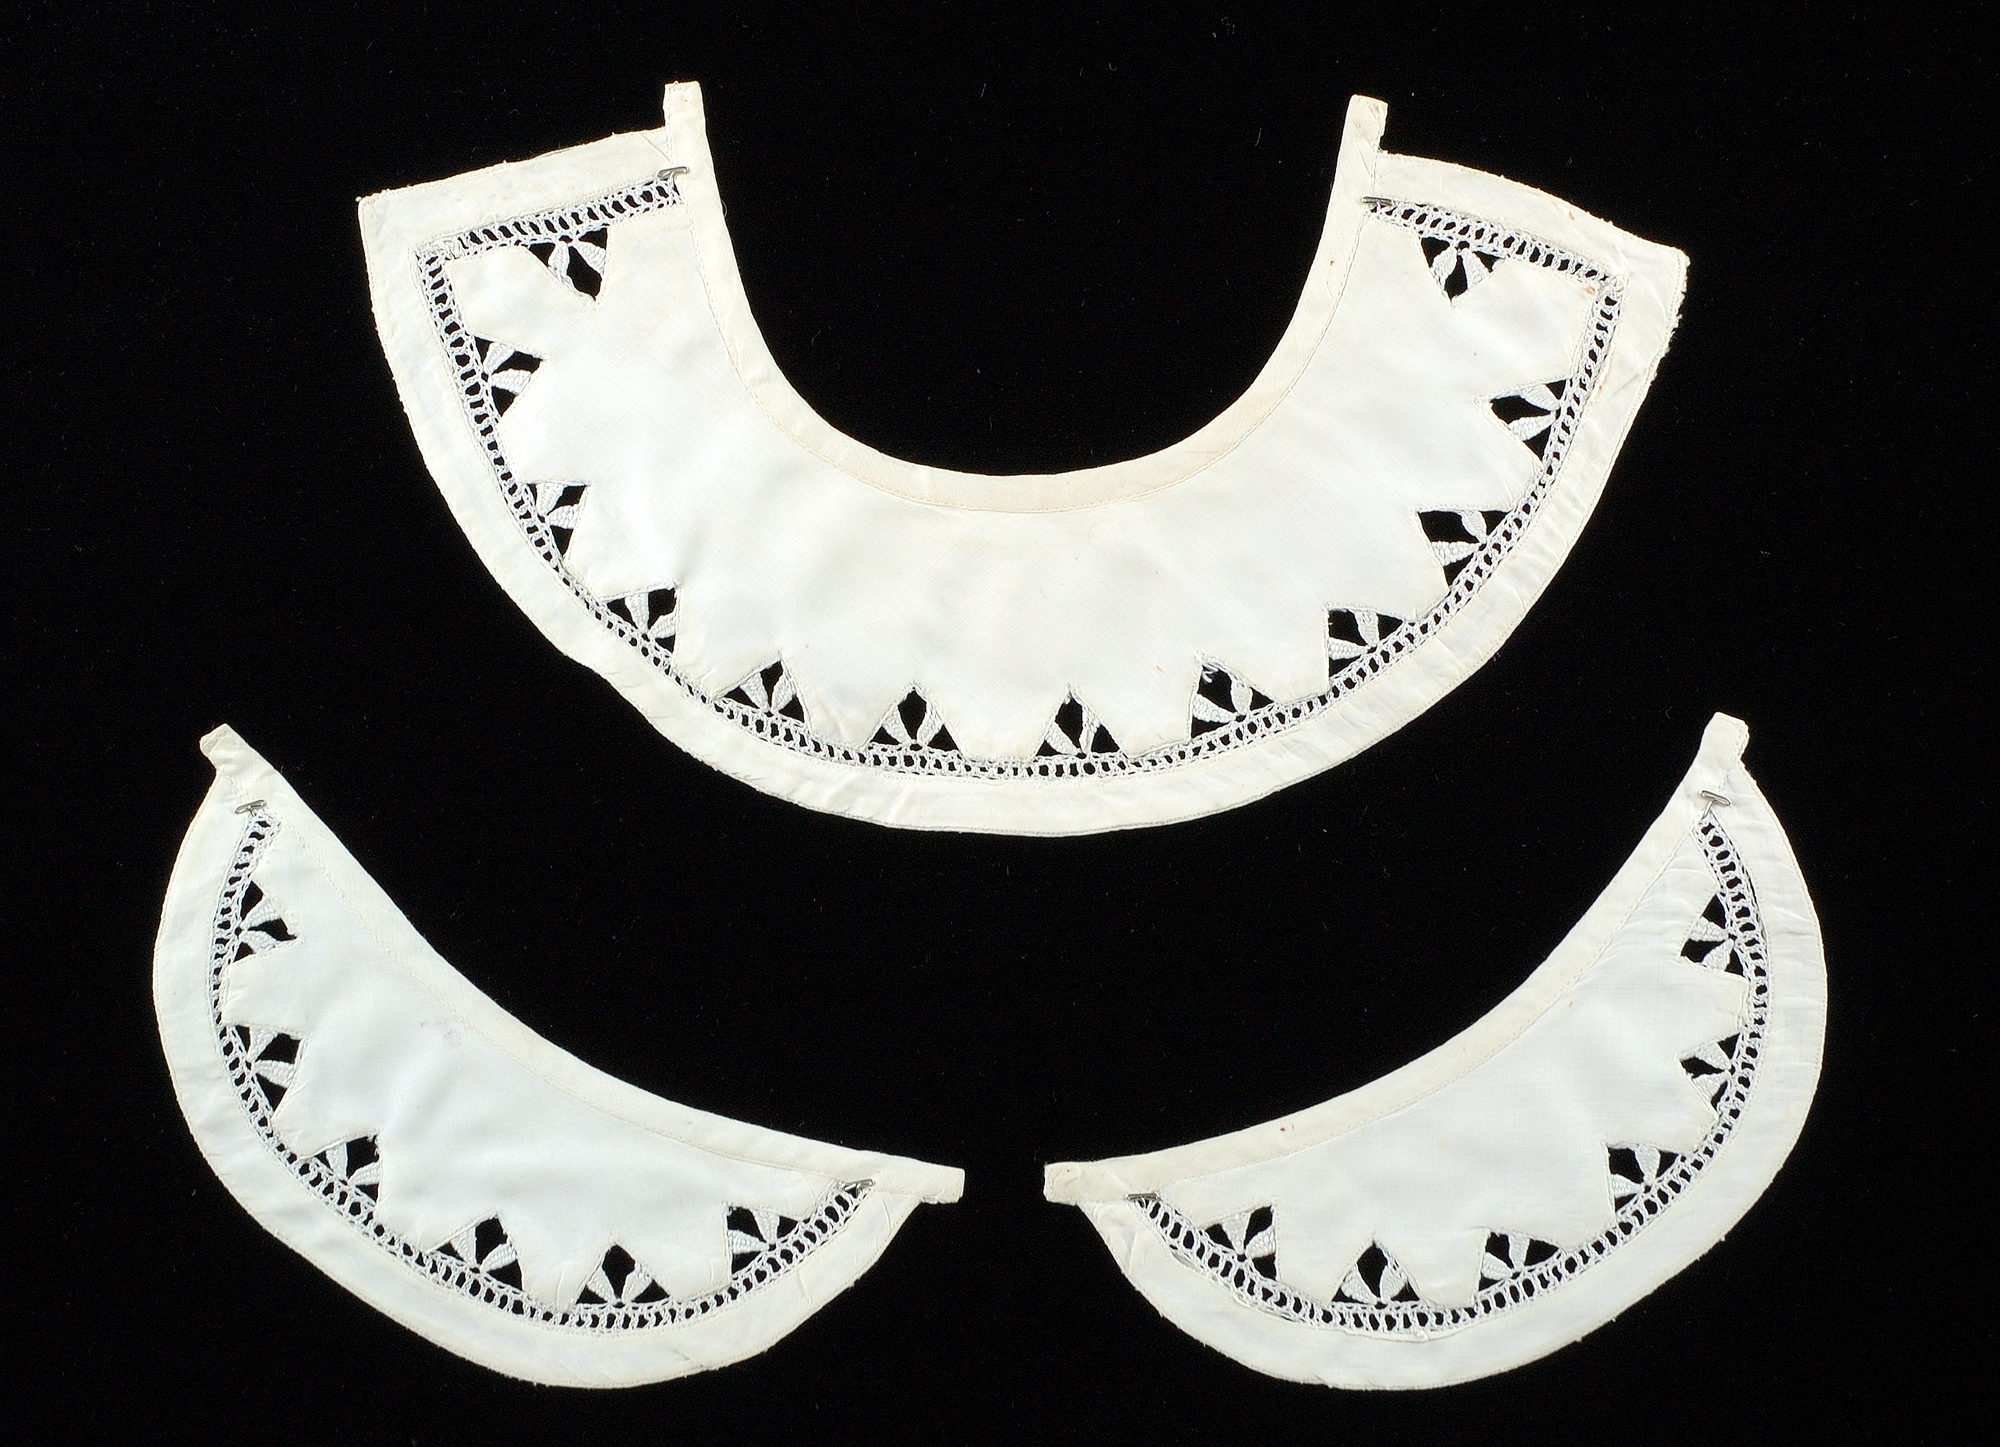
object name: accessory set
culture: american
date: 1850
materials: linen